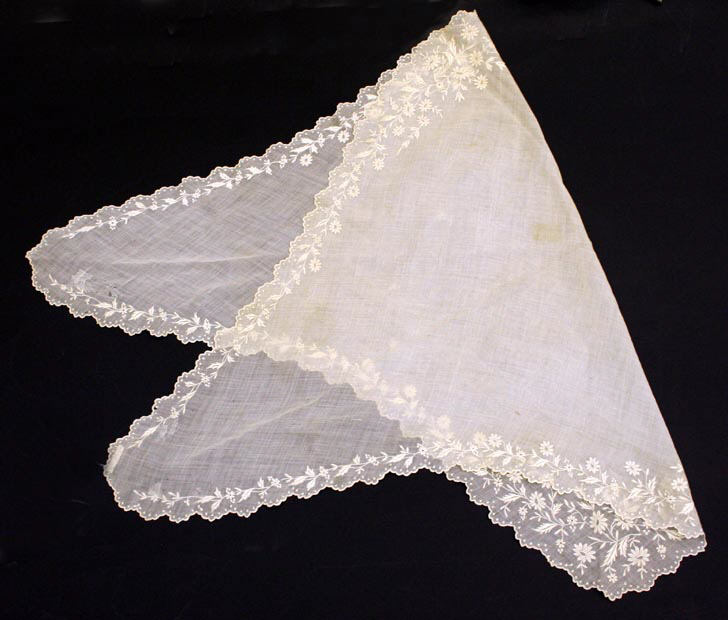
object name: neckerchief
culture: american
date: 1701-1800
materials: cotton